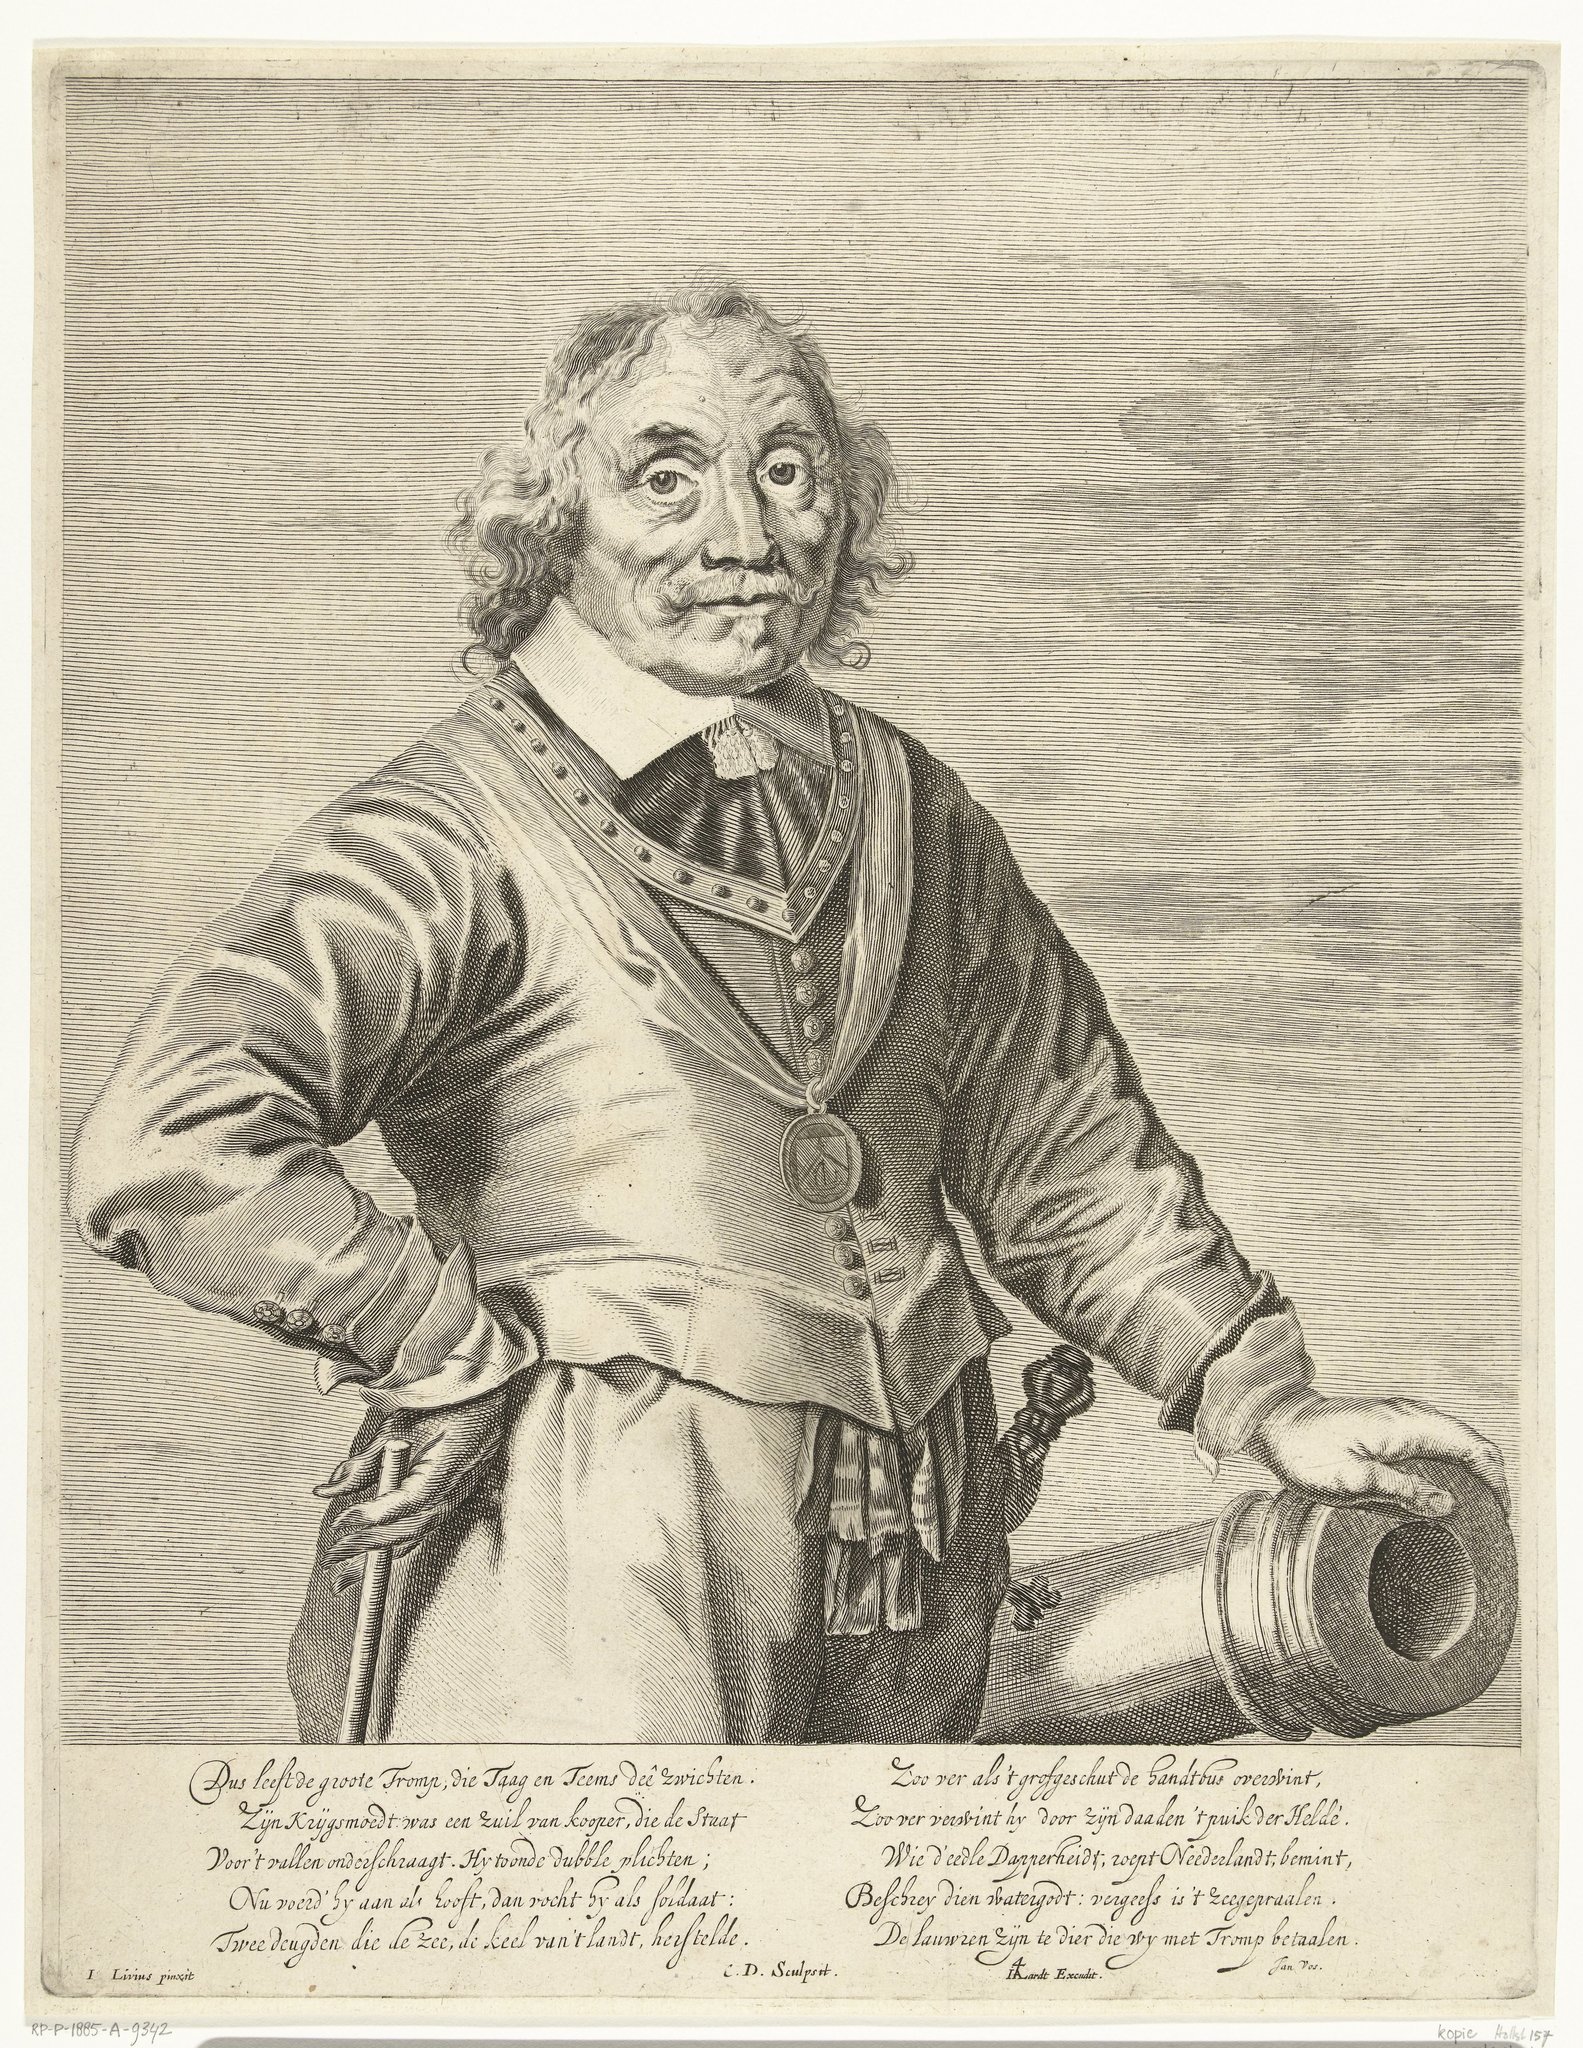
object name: print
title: Portret van Maarten Harpertszoon Tromp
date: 1648-1664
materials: paper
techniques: engraving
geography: amsterdam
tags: brielle, maarten harpertszoon tromp, historical persons, commander-in-chief, admiral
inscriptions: collector's mark: Lugt 2228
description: Prent naar schilderij van Jan Lievens. Hollstein vermeld deze prent niet, het betreft een kopie in de eerste staat.